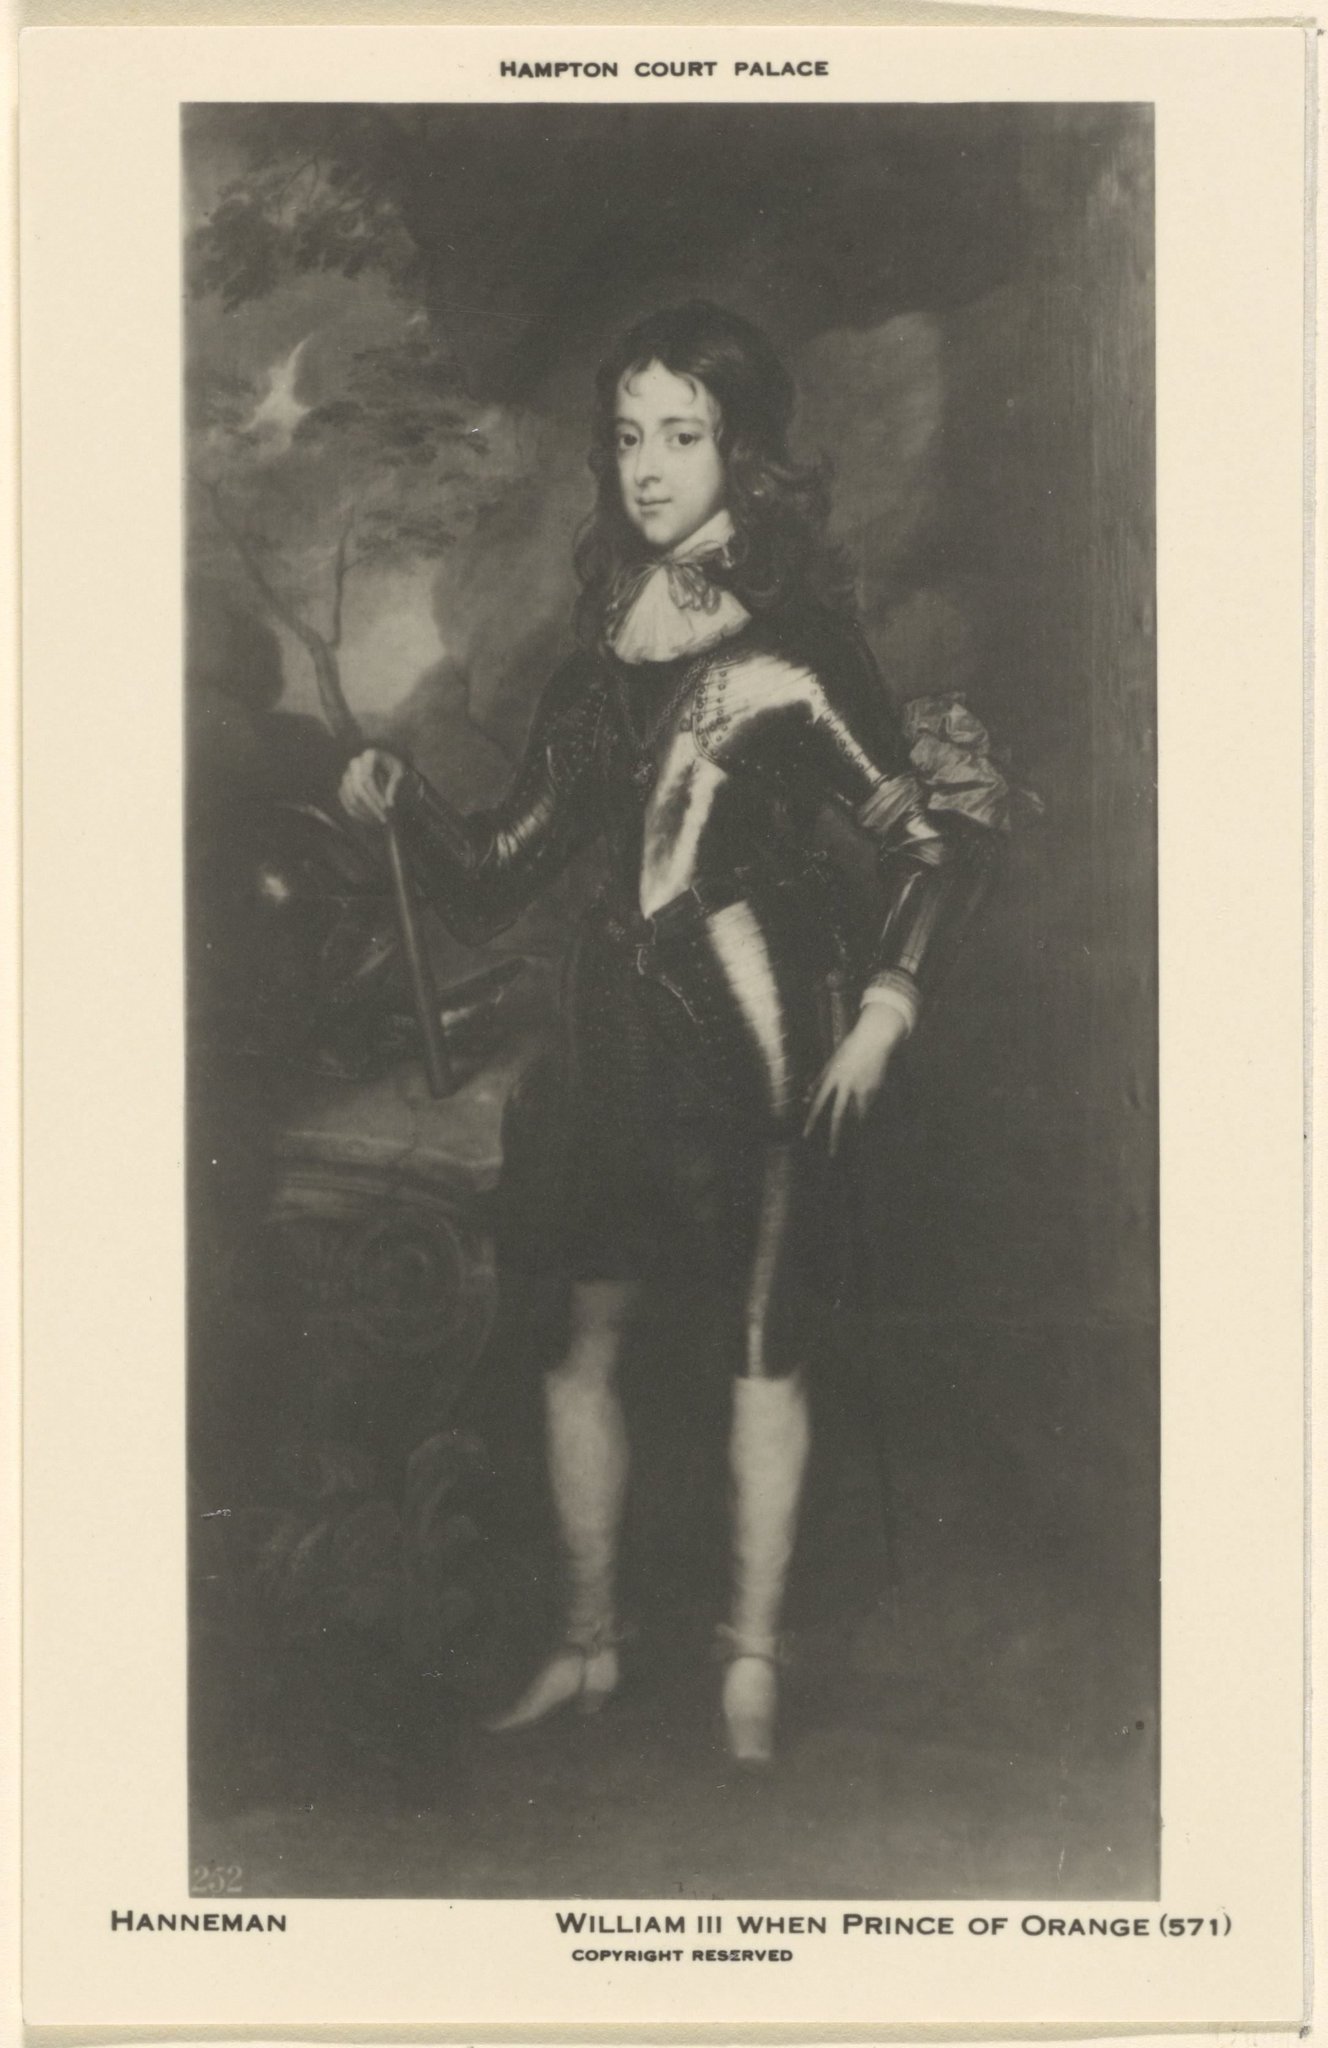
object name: ansichtkaart, prentbriefkaart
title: Portret van Willem III, prins van Oranje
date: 1850-1949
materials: photographic support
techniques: photography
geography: netherlands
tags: william iii (prince of orange and king of england, scotland, and ireland)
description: De hier vermelde titel verwijst naar de hoogst verkregen titel van de geportretteerde, niet per se naar de titel die de geportretteerde op deze voorstelling draagt.